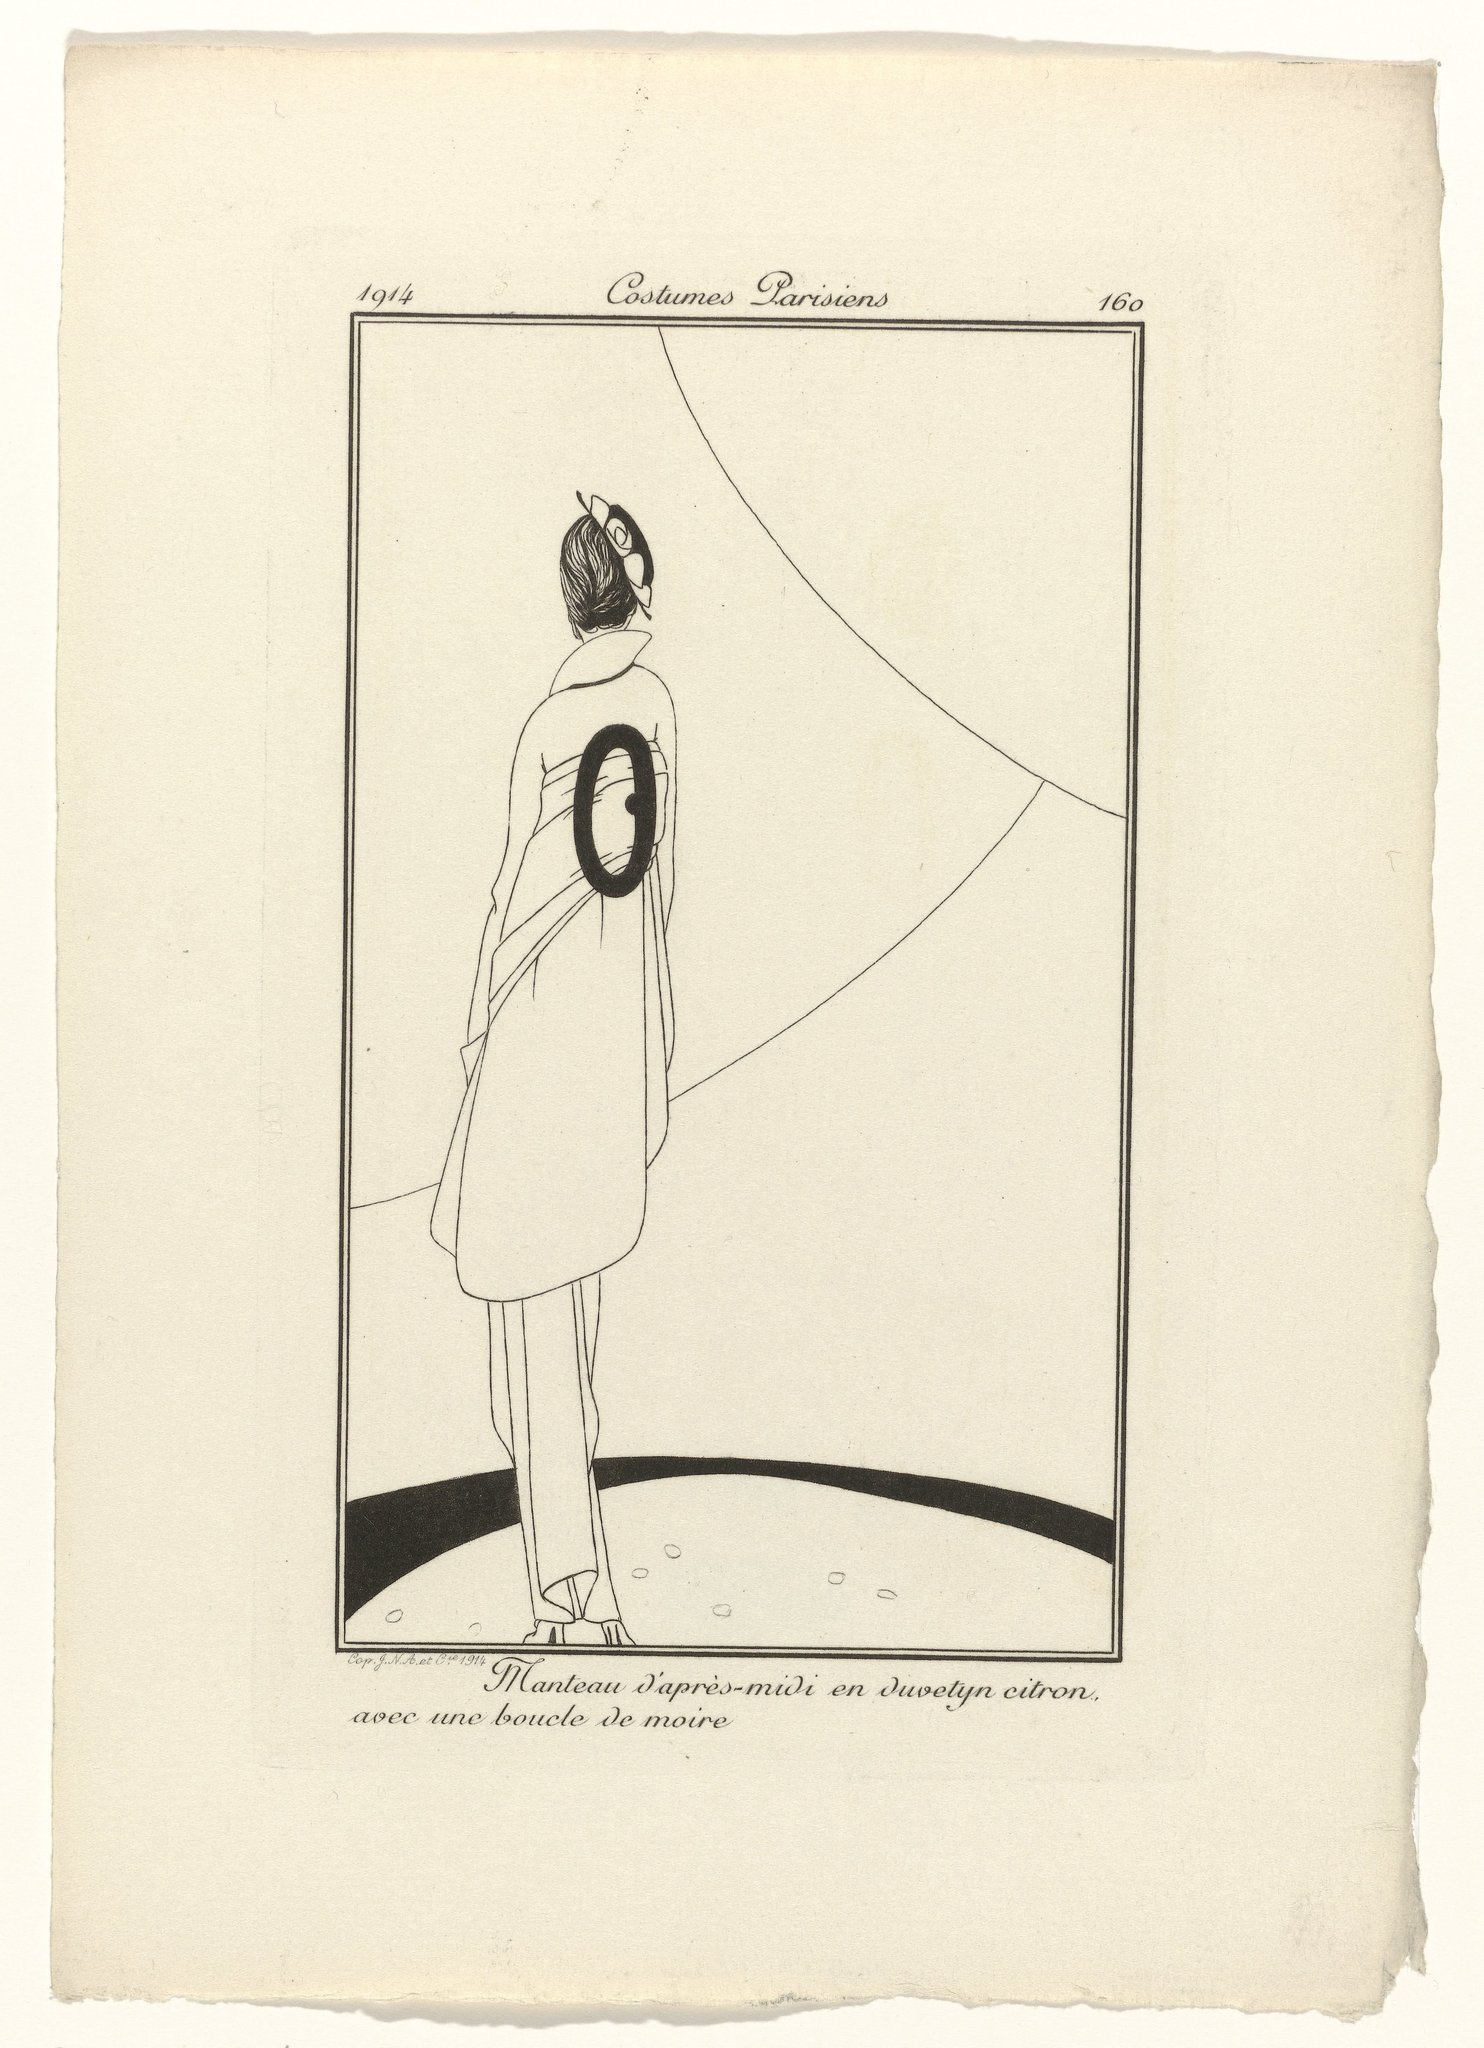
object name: fashion print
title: Journal des Dames et des Modes, Costumes Parisiens, 1914, No. 160 : Manteau d'après-midi, (...)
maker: Anonymous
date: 1914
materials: paper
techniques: engraving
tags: buckle (+ women's clothes), coat (+ women's clothes), head-gear (+ women's clothes), fashion plates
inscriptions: caption: ‘Manteau d'après-midi, en duvetyn citron, avec une boucle de moire.’, title: ‘Costumes Parisiens’, inscription: ‘Cop. J. N. A. et Cie 1914’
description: Mantel voor de middag van citroengeel 'duvetyne', met een gesp van 'moire'. Proefdruk van een prent uit het modetijdschrift Journal des Dames et des Modes (1912-1914).